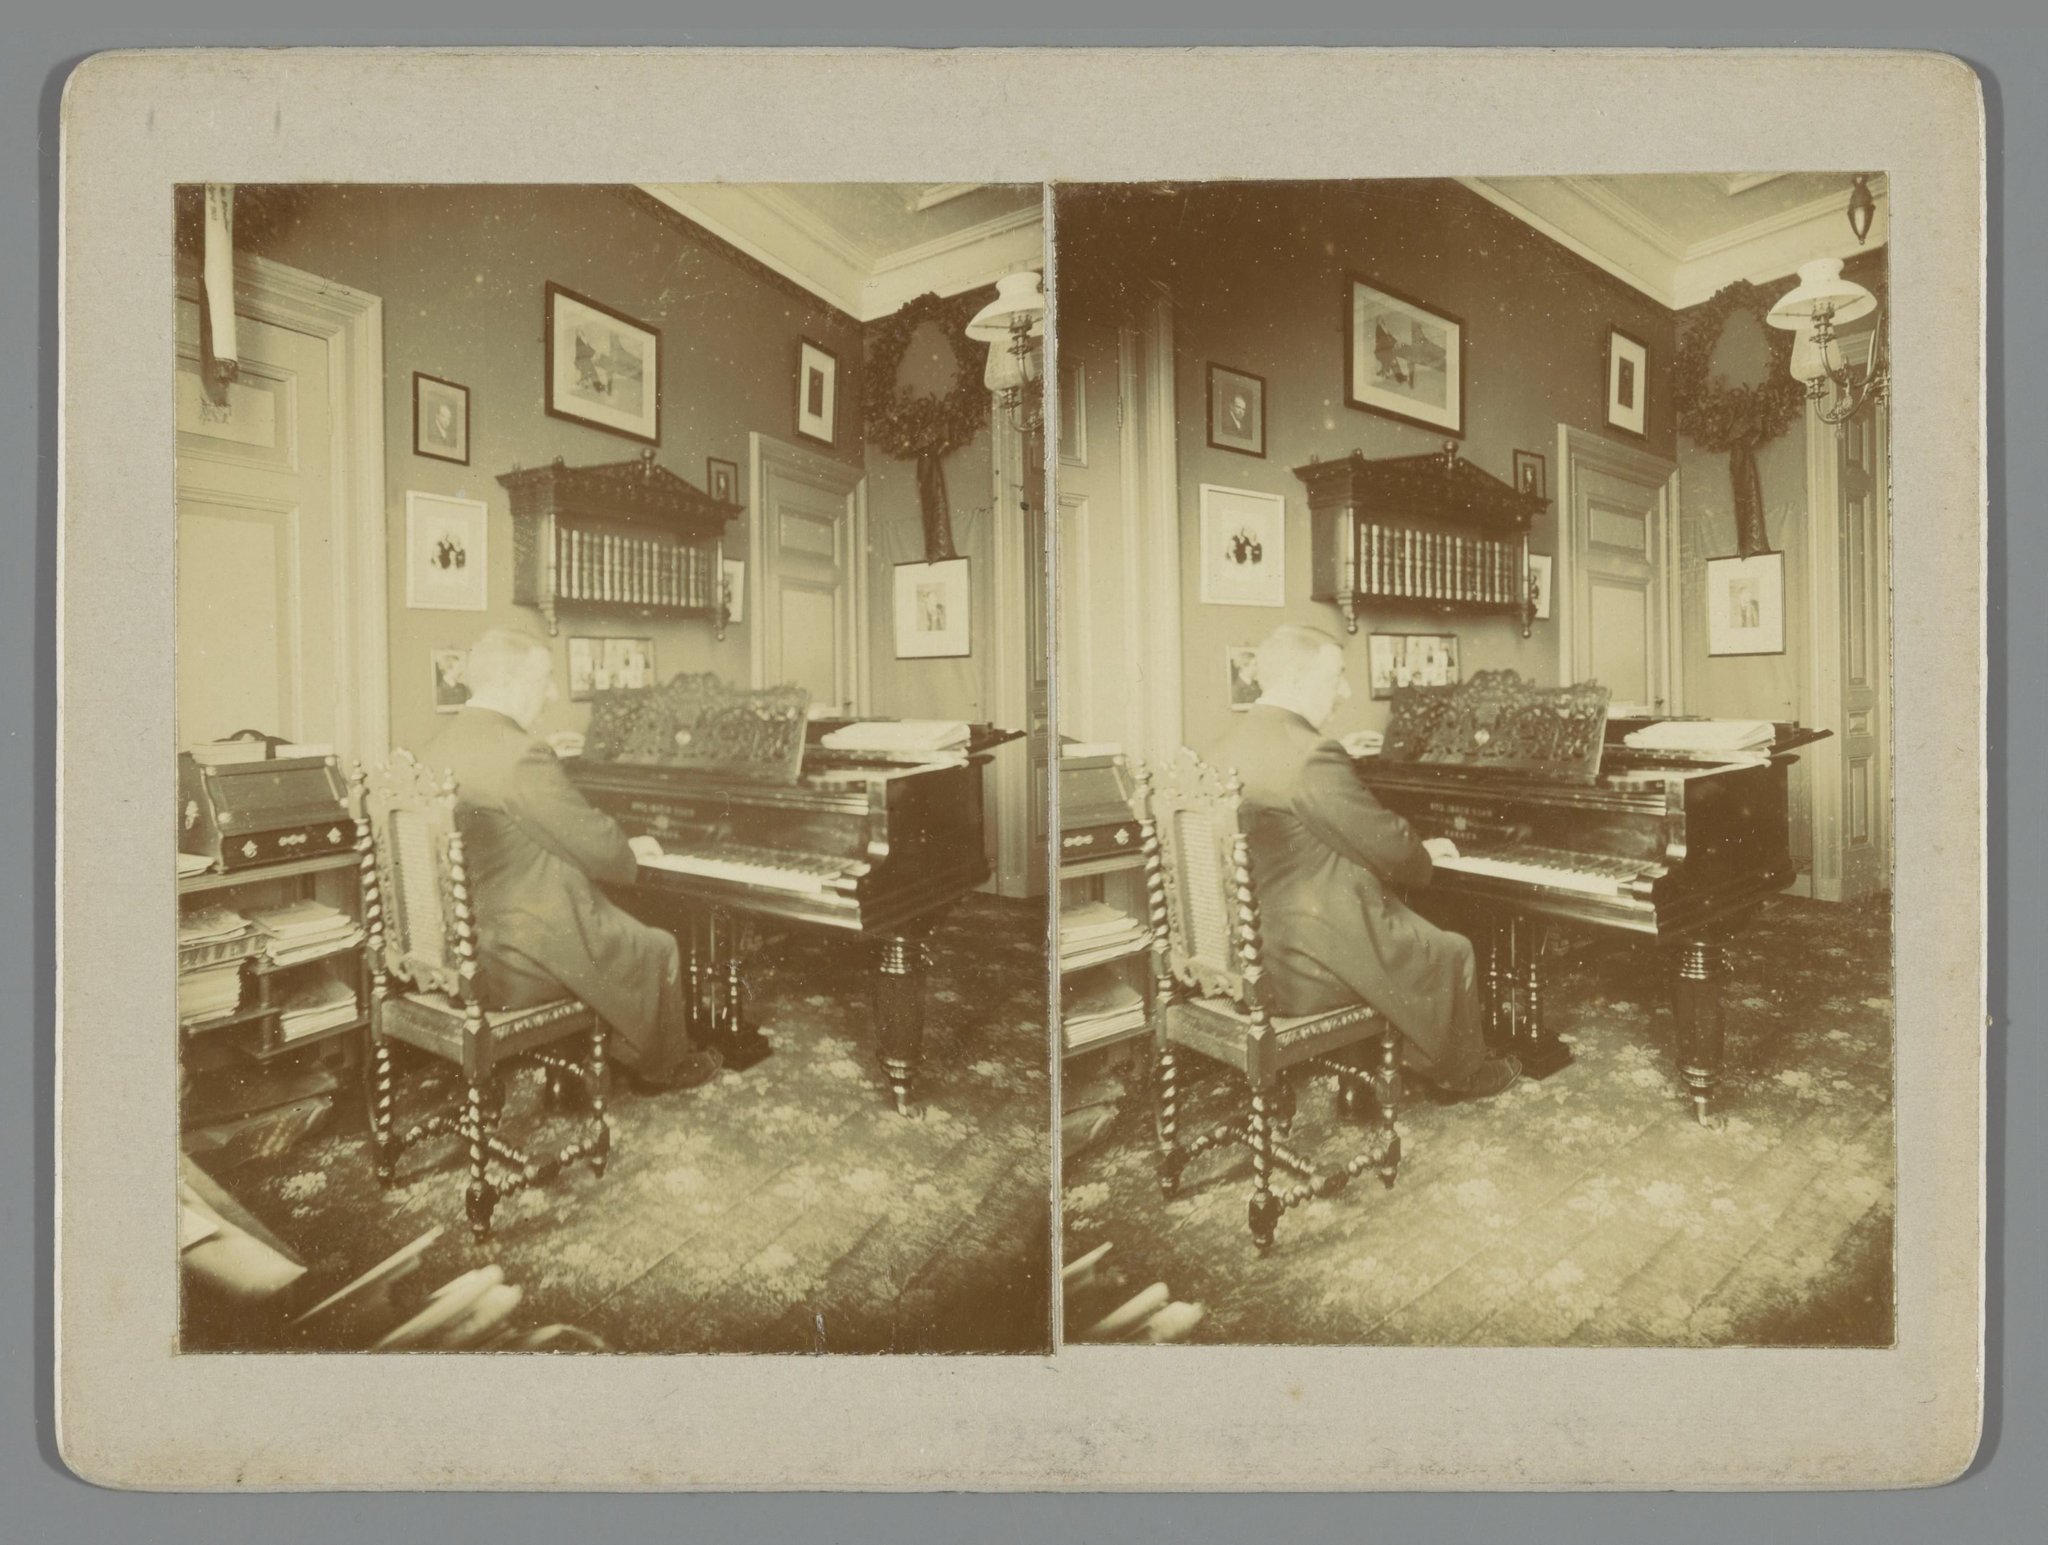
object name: stereograph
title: Man achter een piano, vermoedelijk de Utrechtse pianist Wouter Hutschenruyter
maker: Anonymous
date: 1900-1905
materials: paper, cardboard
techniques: gelatin silver print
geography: utrecht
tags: one person playing keyboard instrument